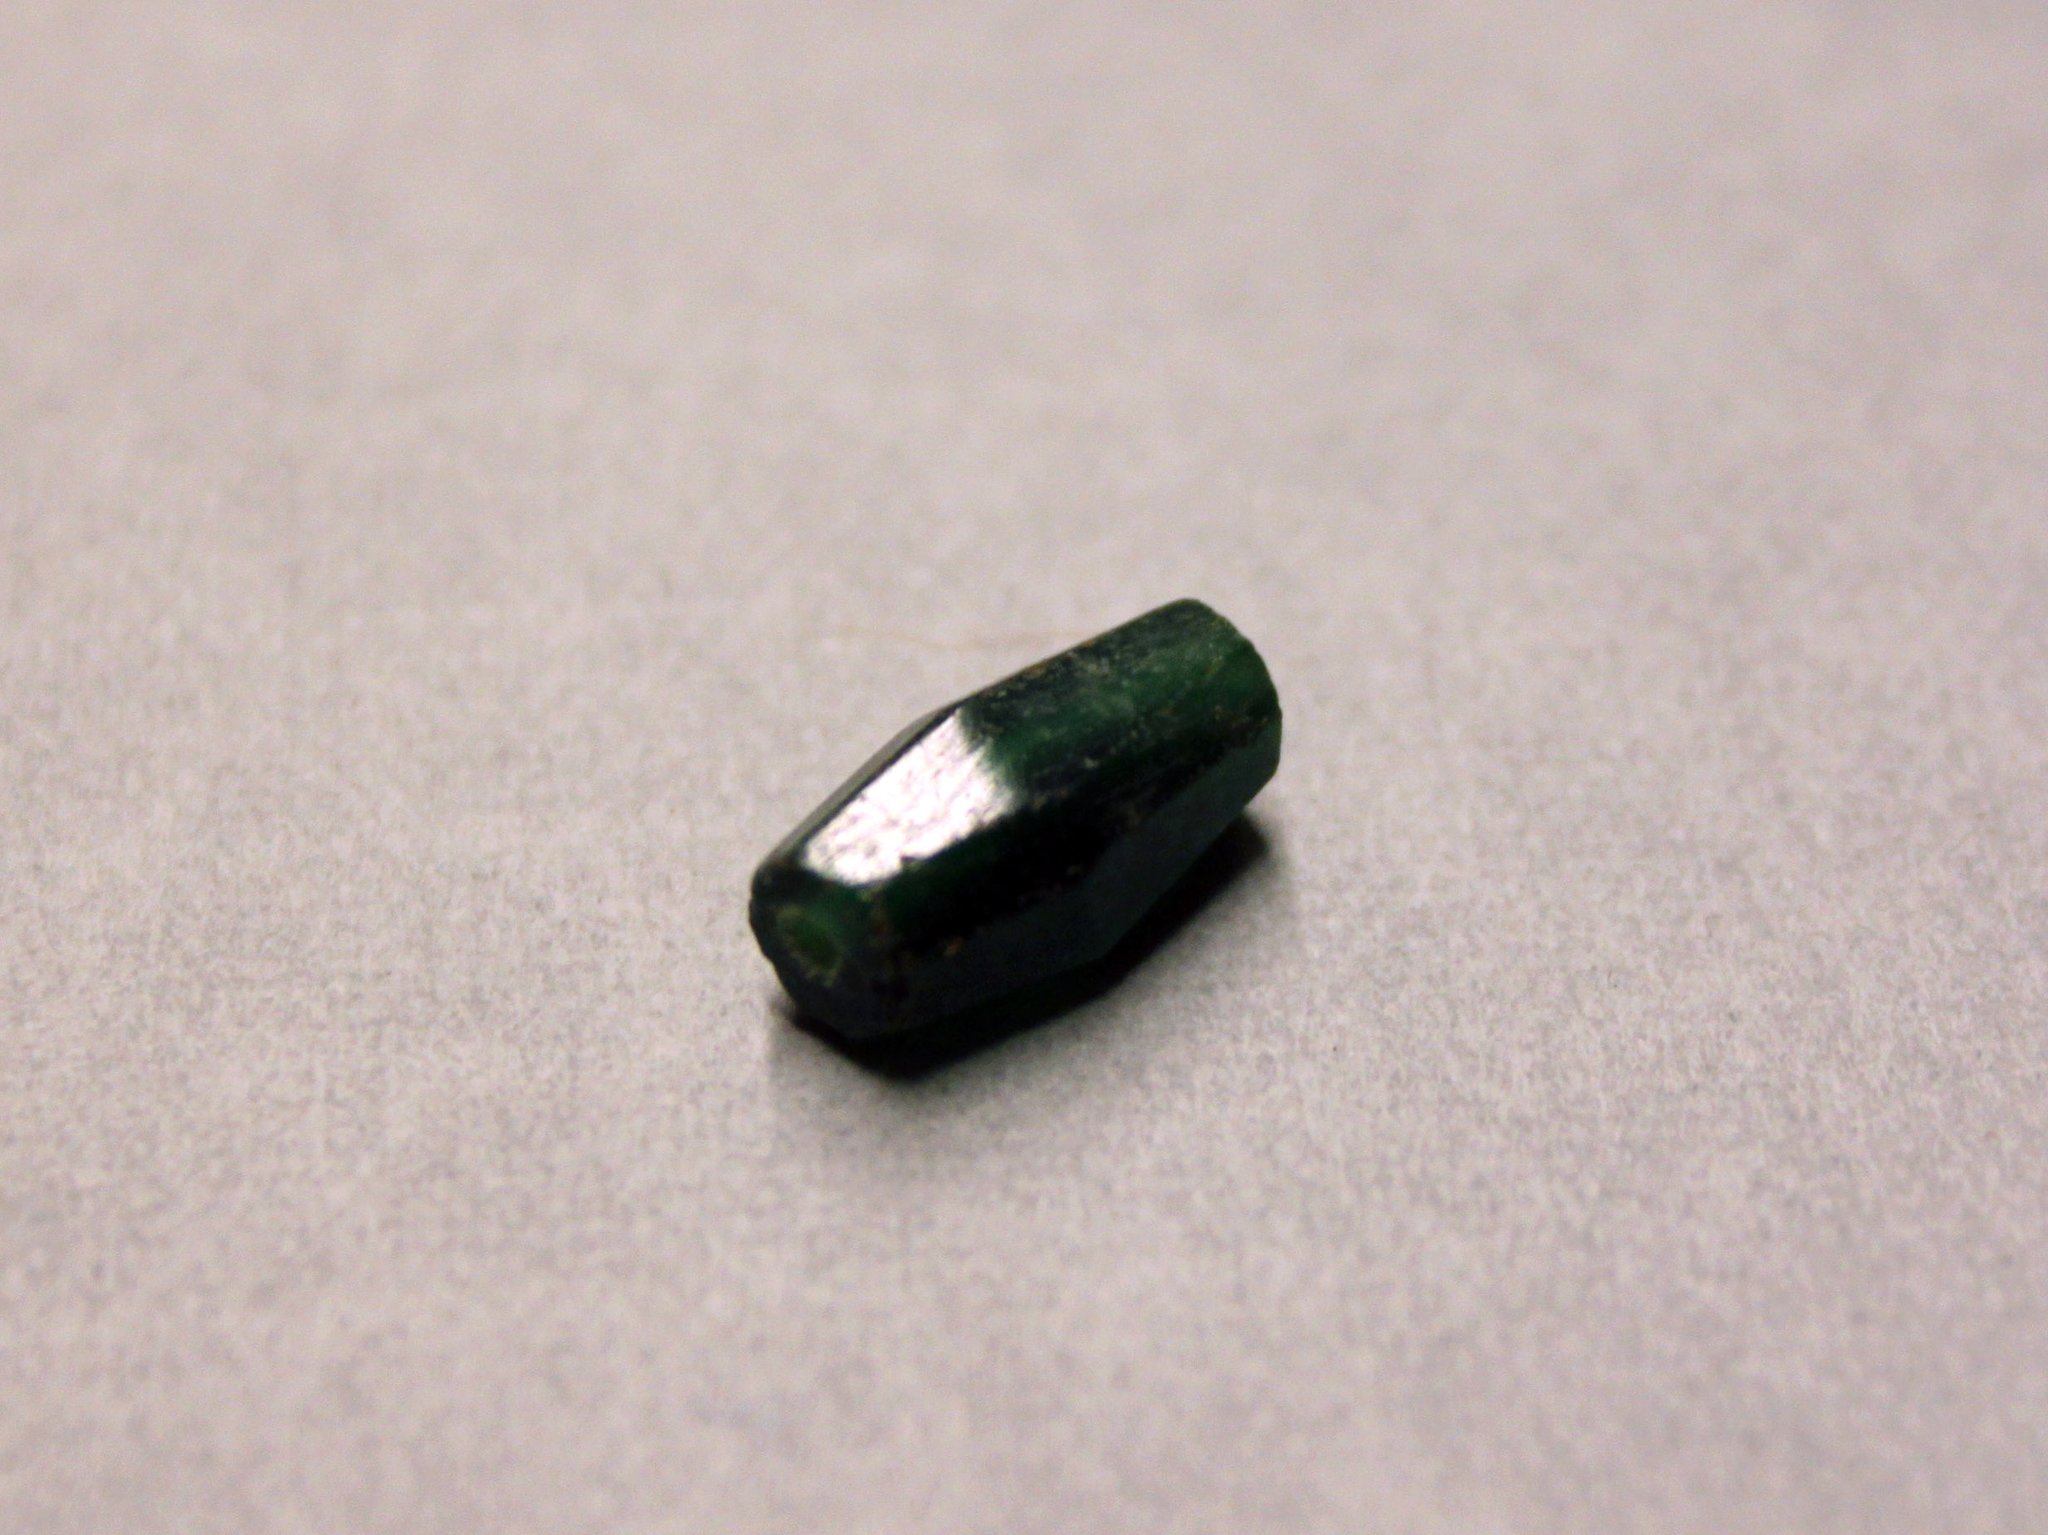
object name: bead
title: Beads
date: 801-1200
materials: glass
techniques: cutting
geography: iran